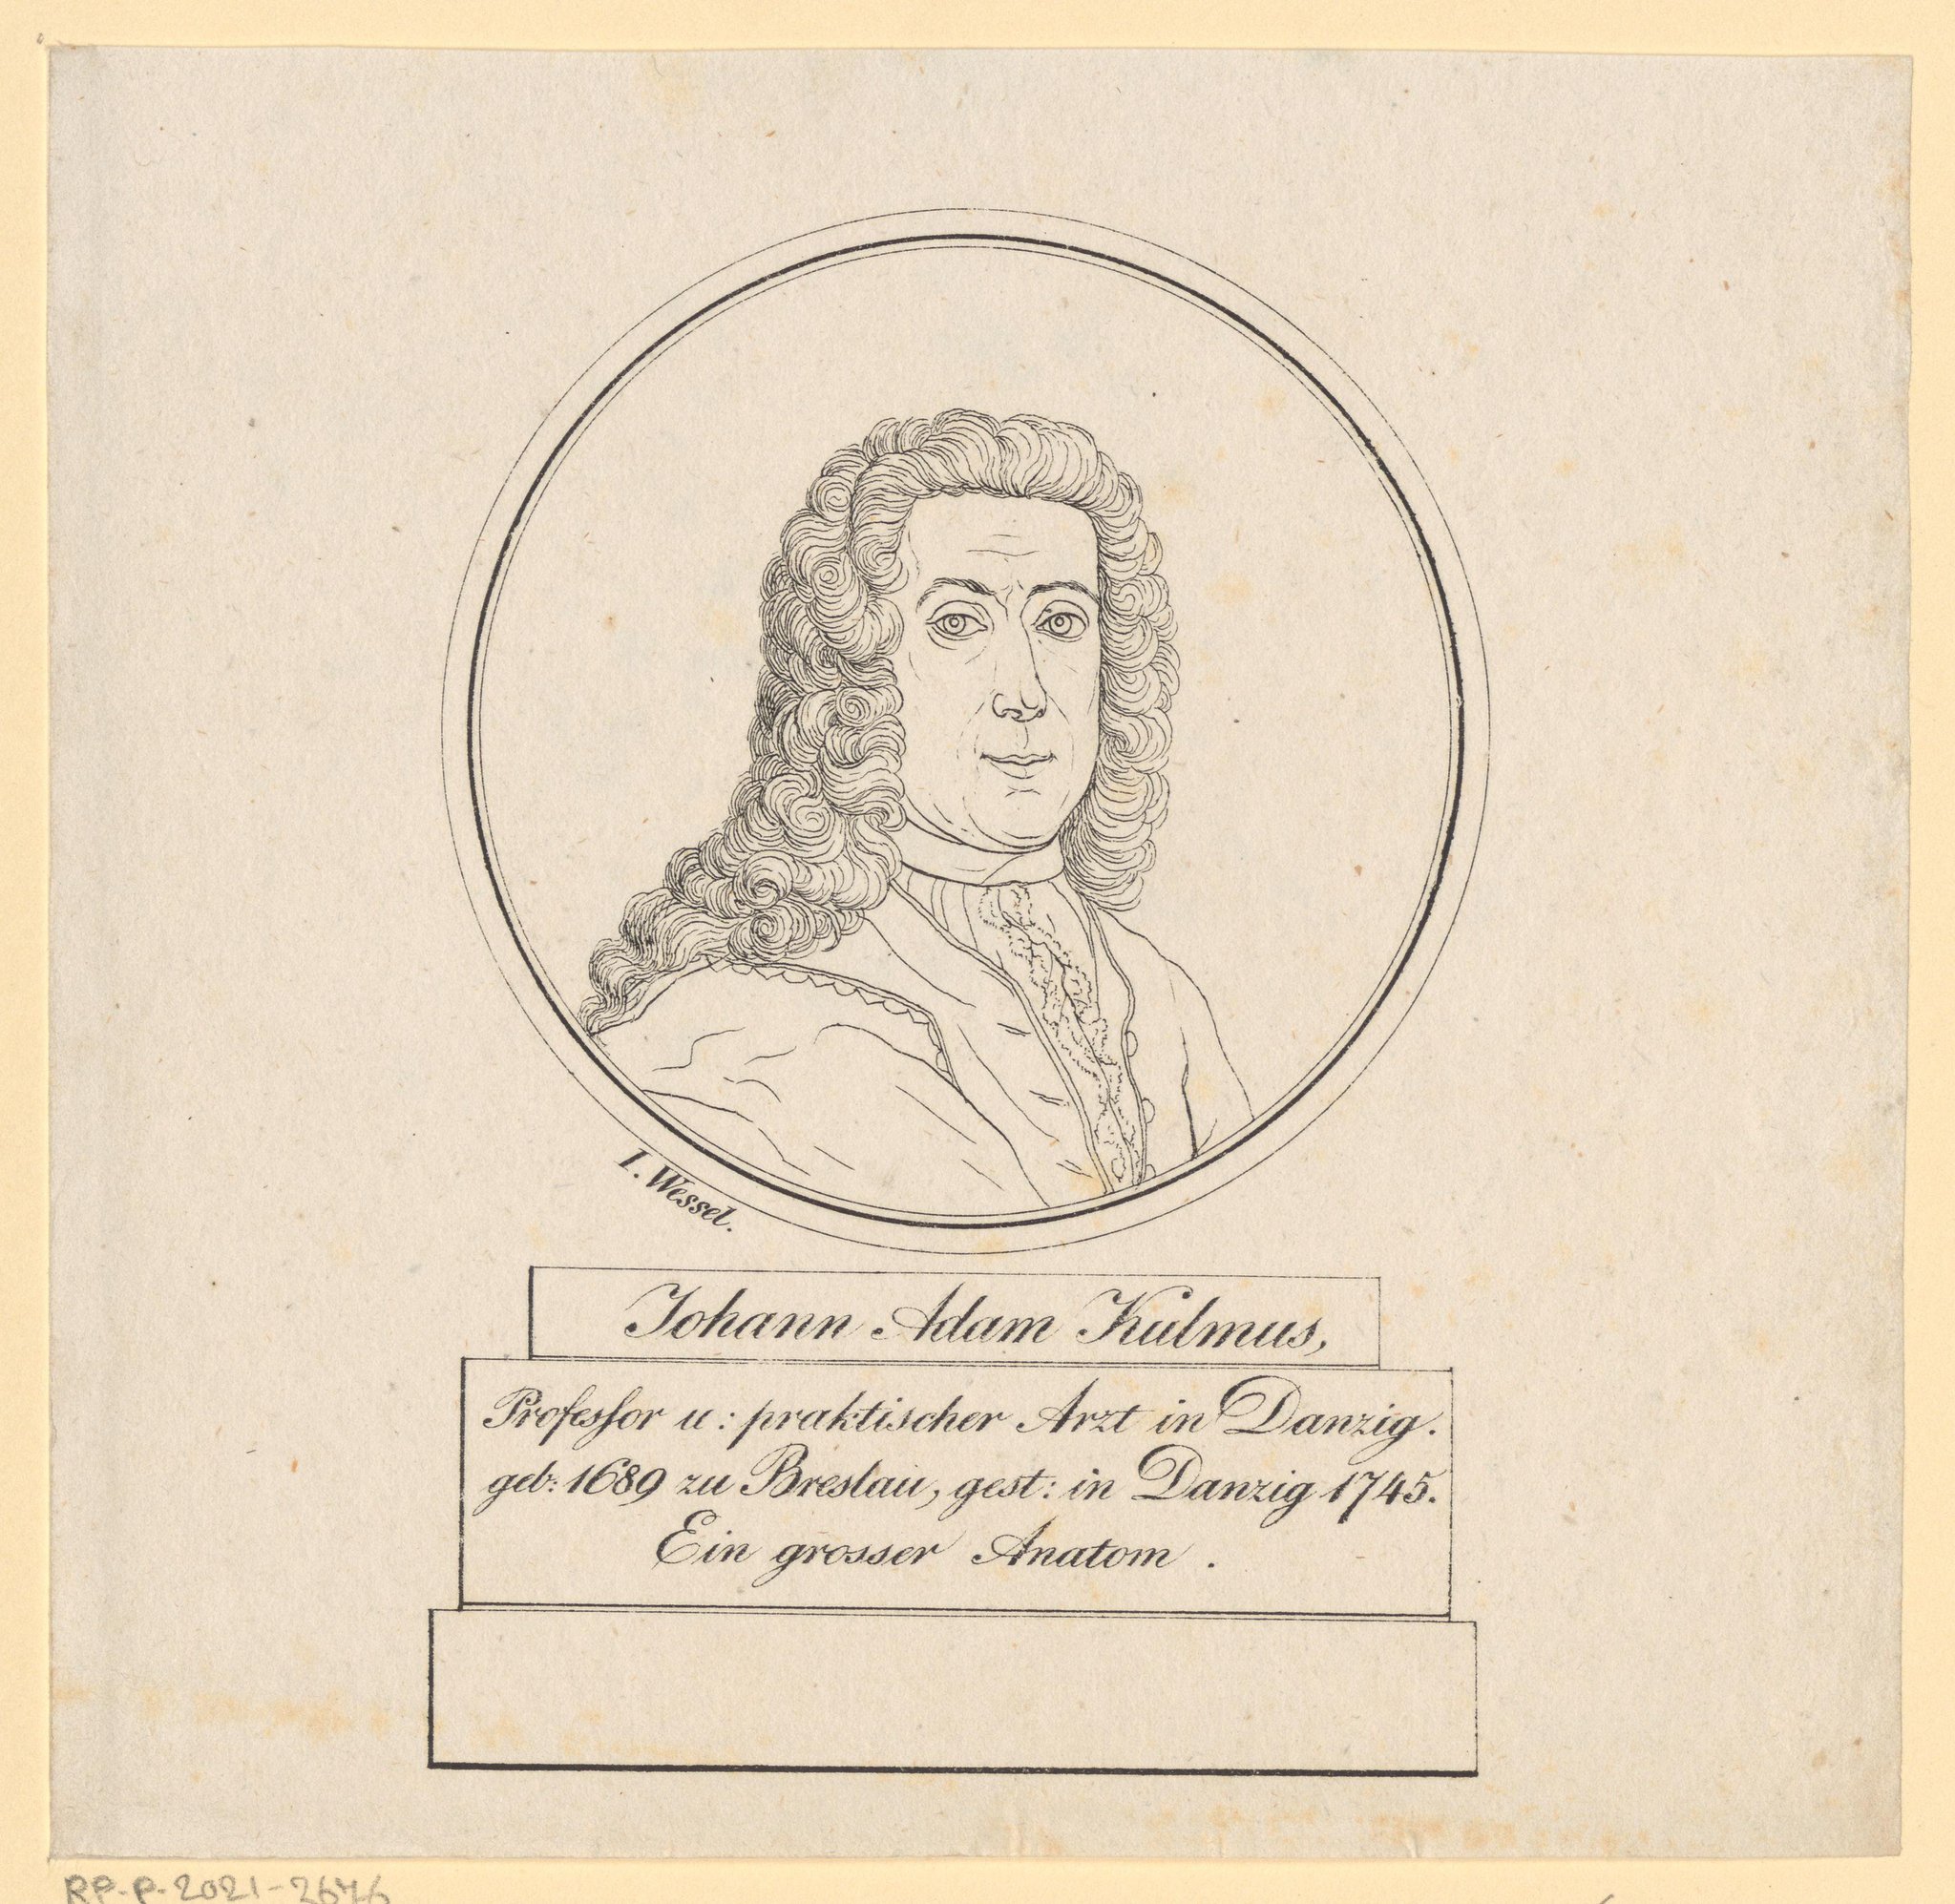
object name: print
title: Portret van Johan Adam Kulmus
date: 1745-1849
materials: paper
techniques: etching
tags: historical persons